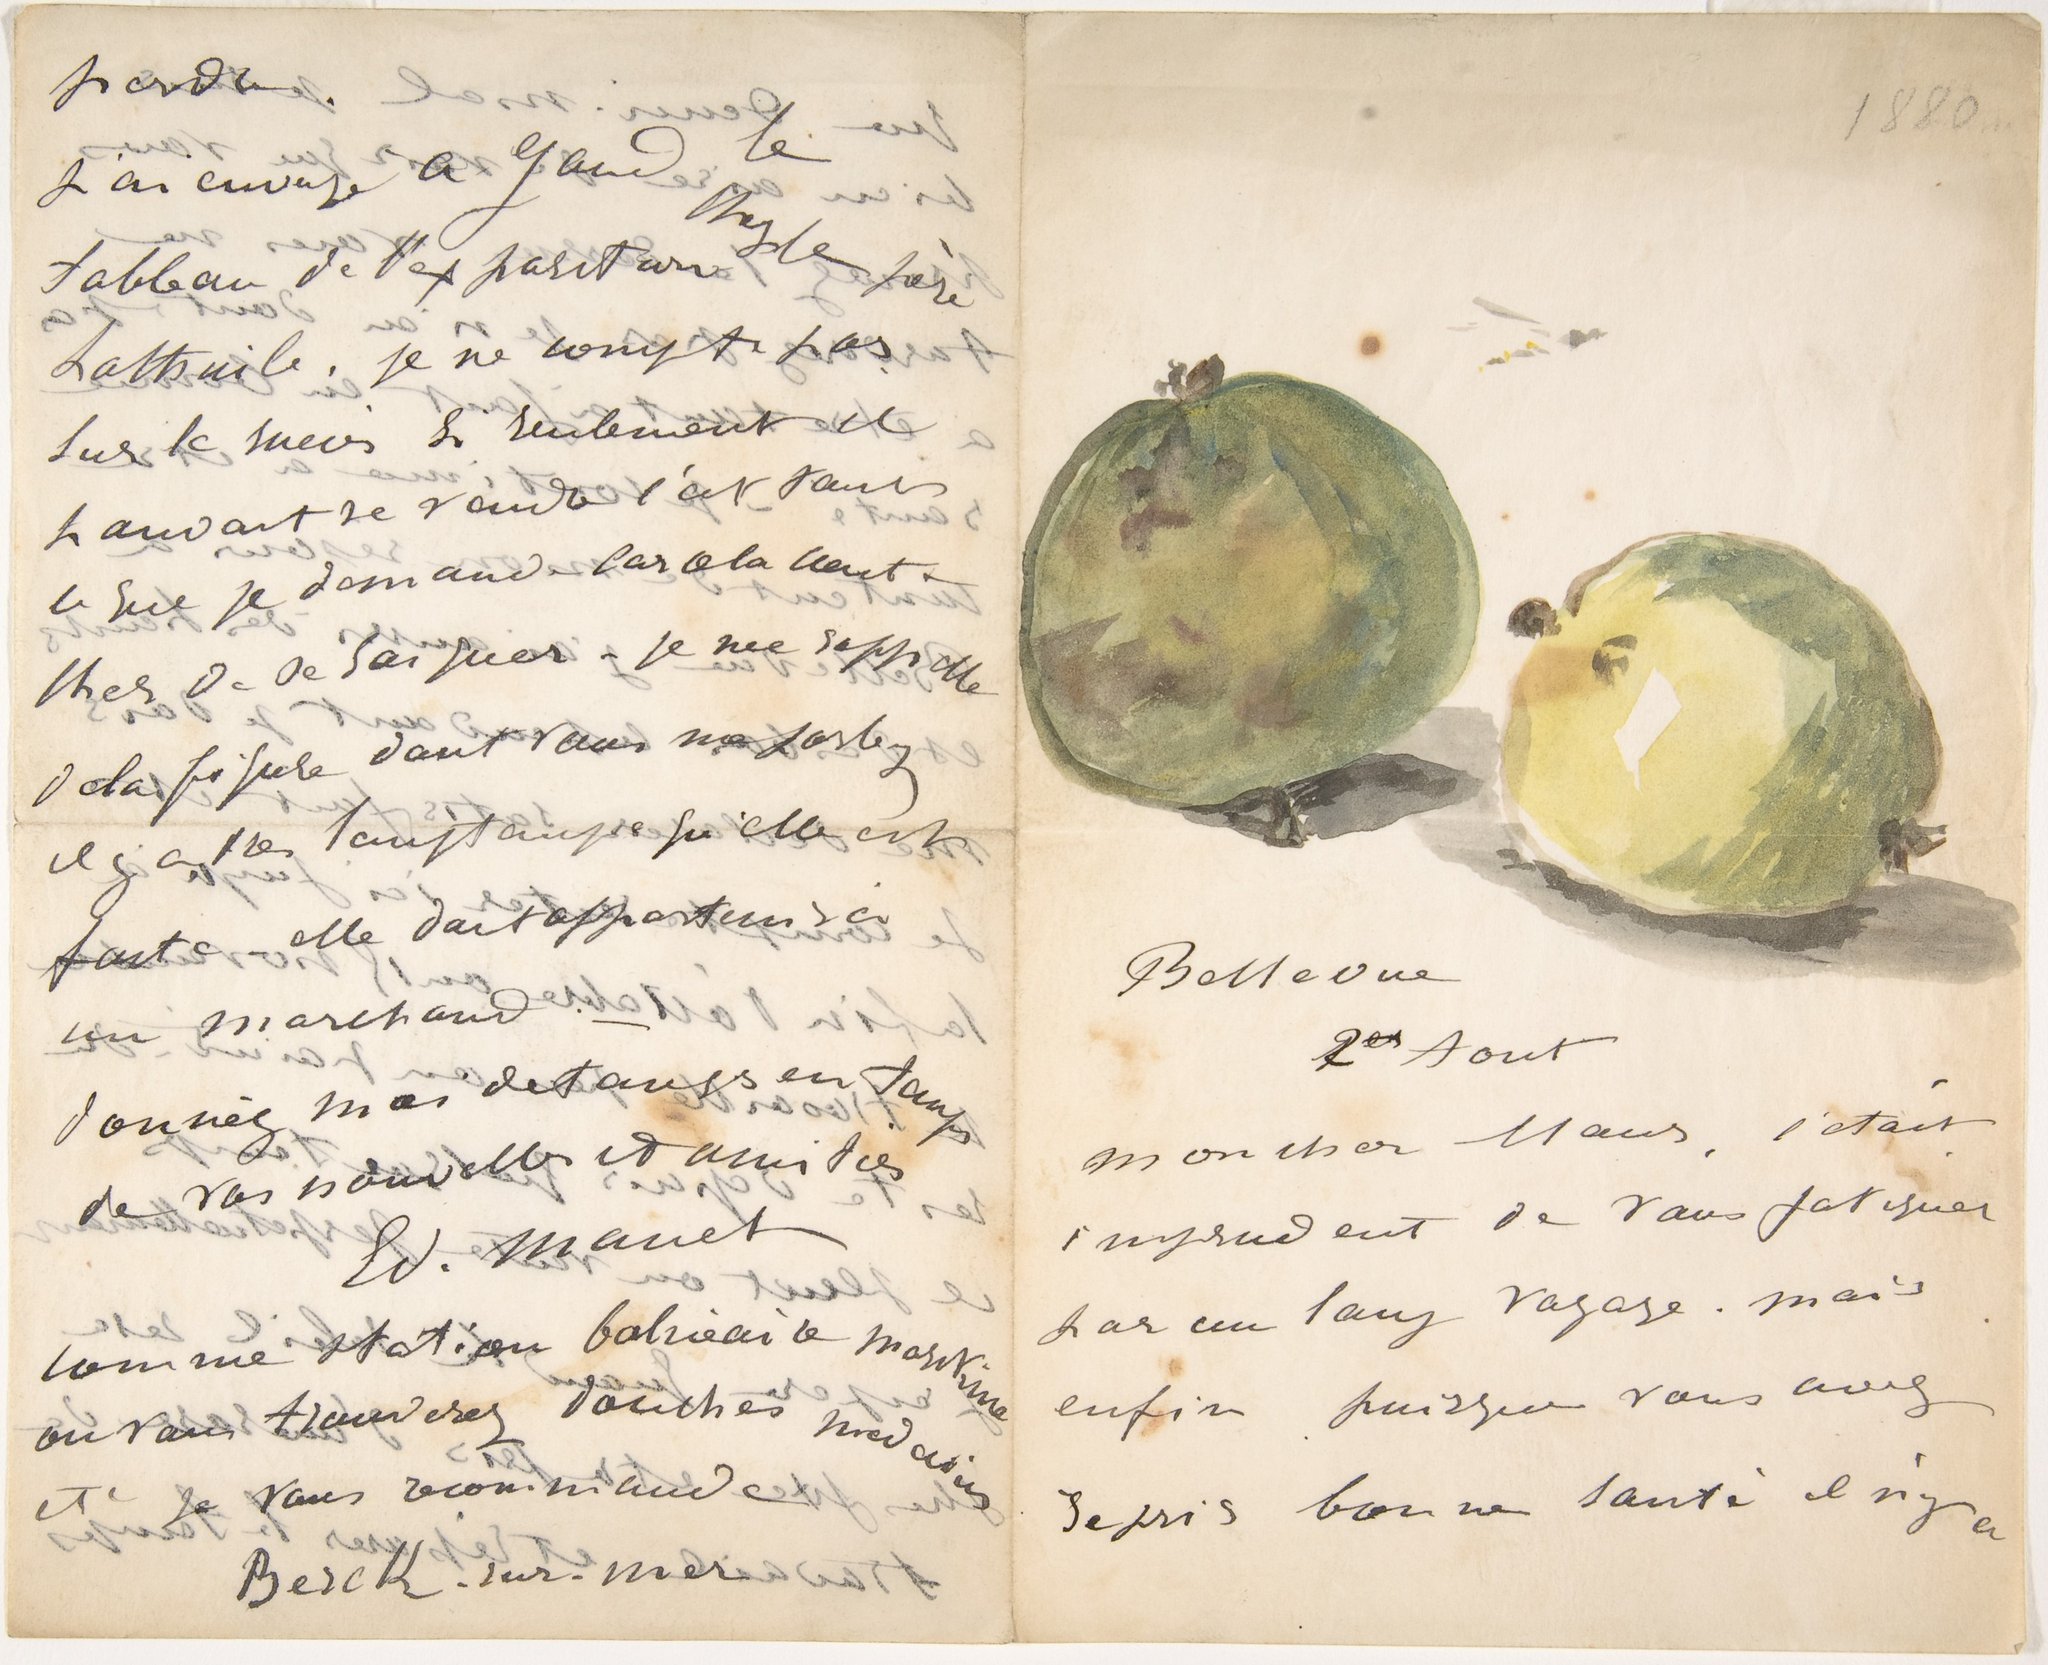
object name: drawing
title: A Letter to Eugène Maus, Decorated with Two Apples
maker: édouard manet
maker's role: artist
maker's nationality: french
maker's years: 1832-1883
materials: ink, watercolor, paper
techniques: pen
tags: fruit